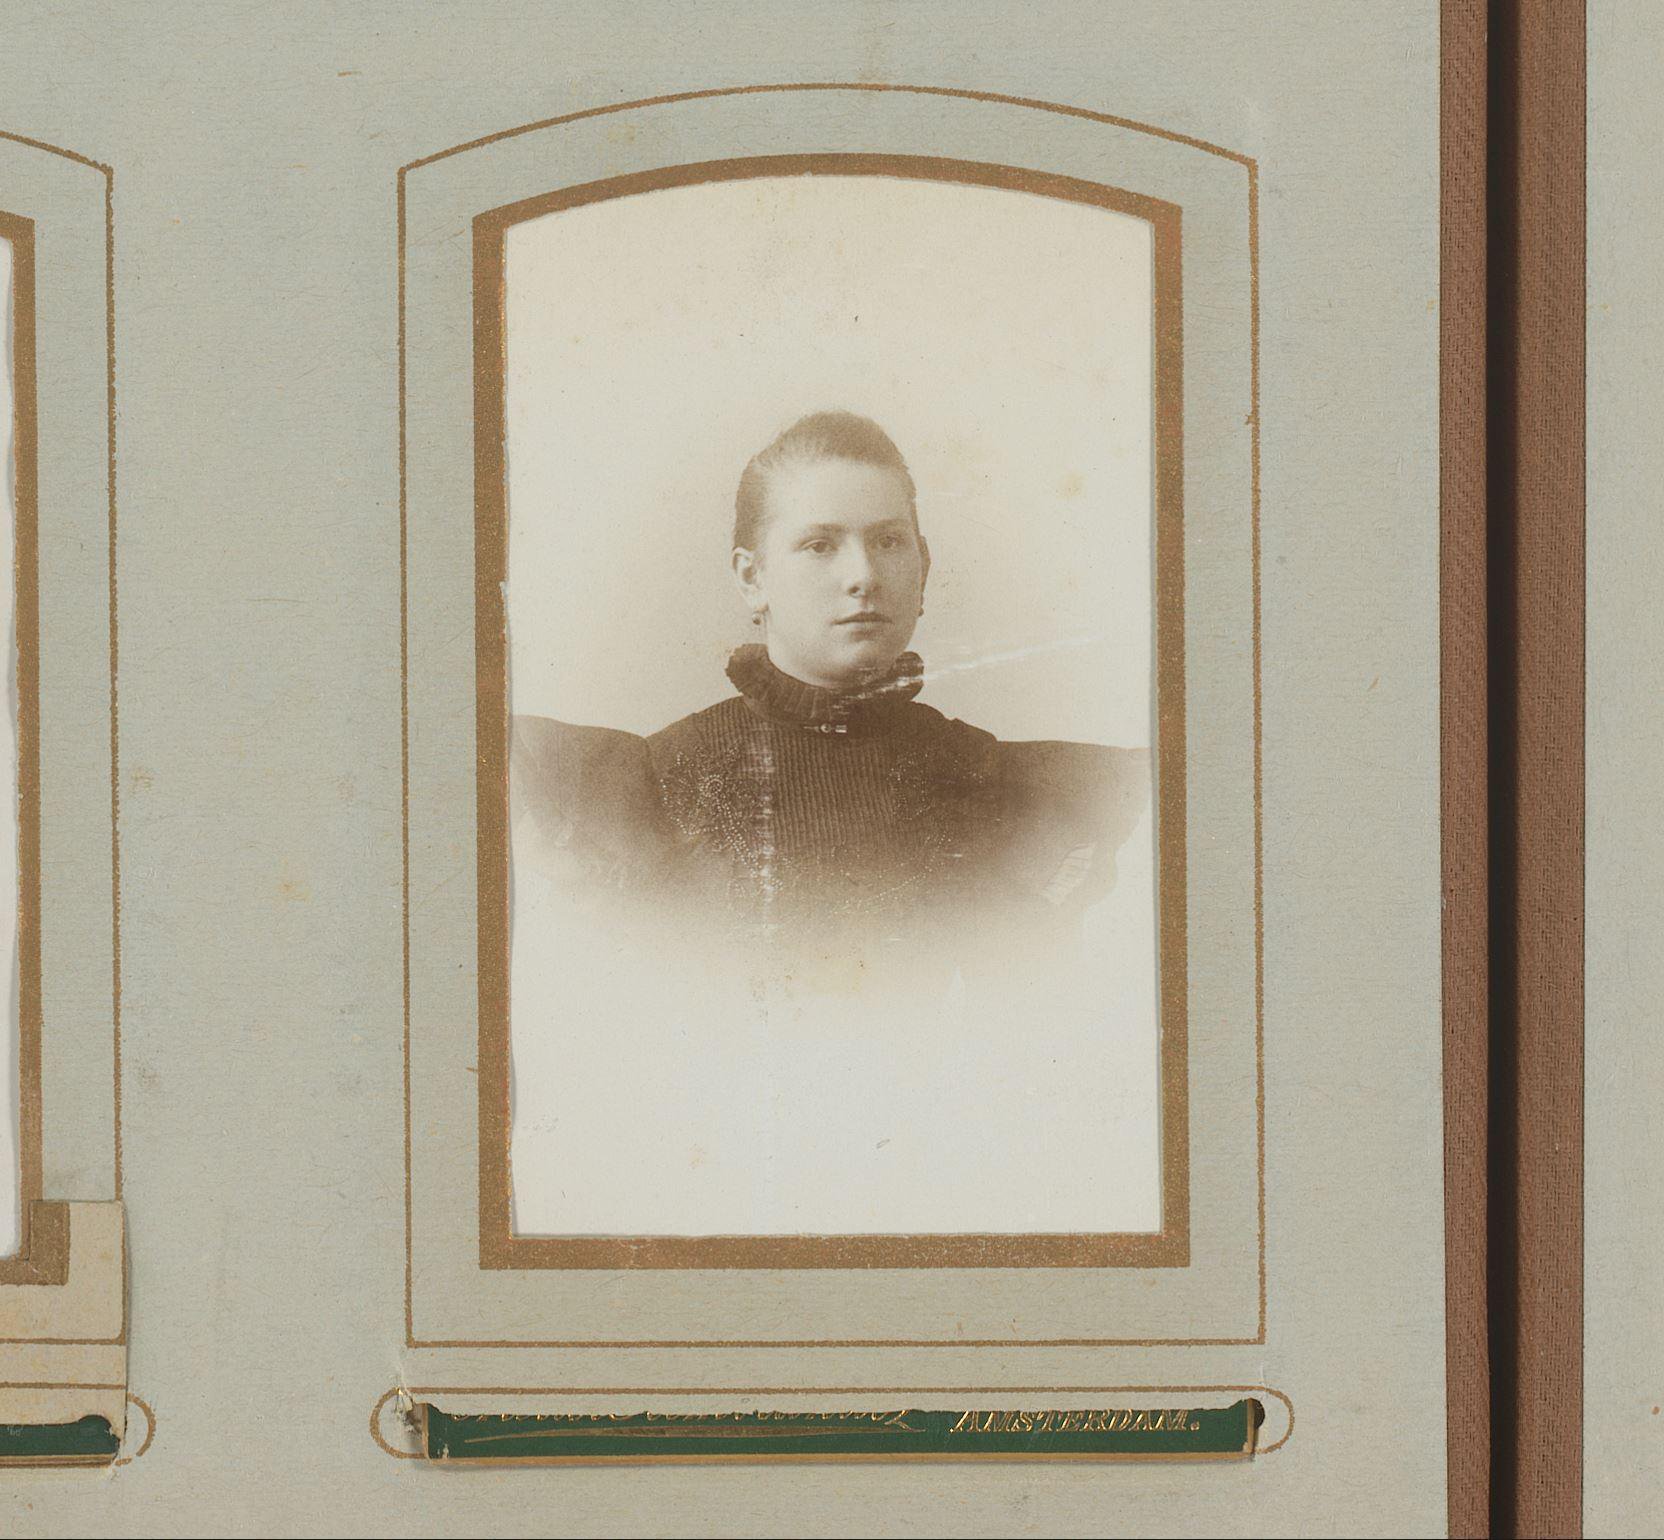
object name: carte de visite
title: Portret van een jonge vrouw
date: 1880-1920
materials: cardboard, photographic support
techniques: collodion silver print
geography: amsterdam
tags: adolescent, young woman, maiden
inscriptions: inscription: ‘Photographie/ Artistique/ Rembrandt/ Amsterdam/ Rembrandtplein 60’